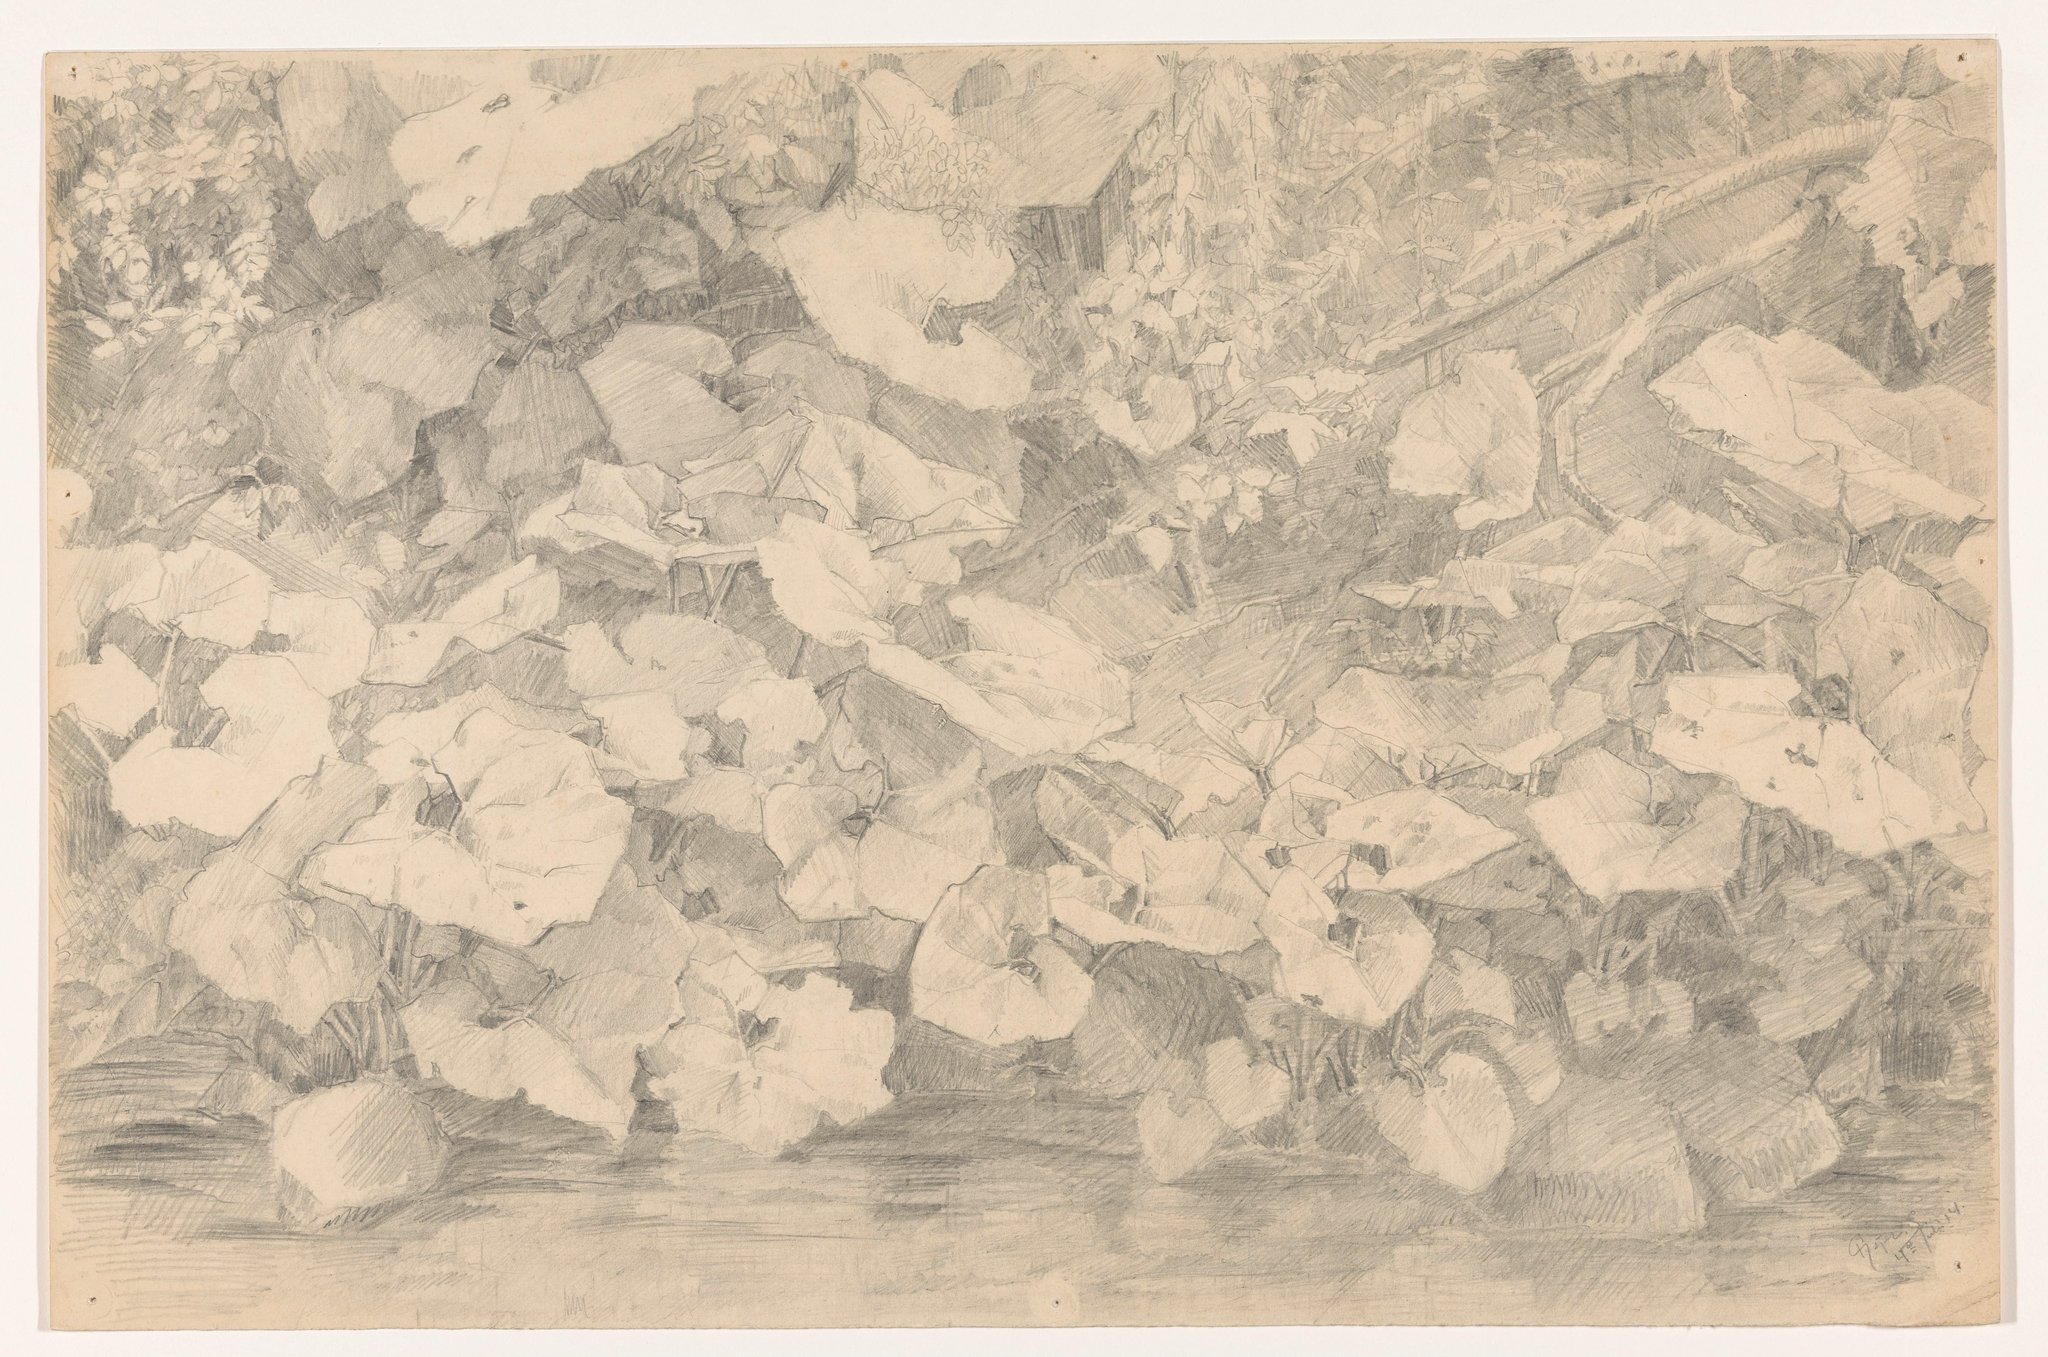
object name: drawing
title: Planten aan de waterkant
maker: reijer stolk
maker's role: draughtsman, print maker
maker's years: 1896-1945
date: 1914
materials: paper, pencil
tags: plants (in general)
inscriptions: collector's mark: Lugt 2228